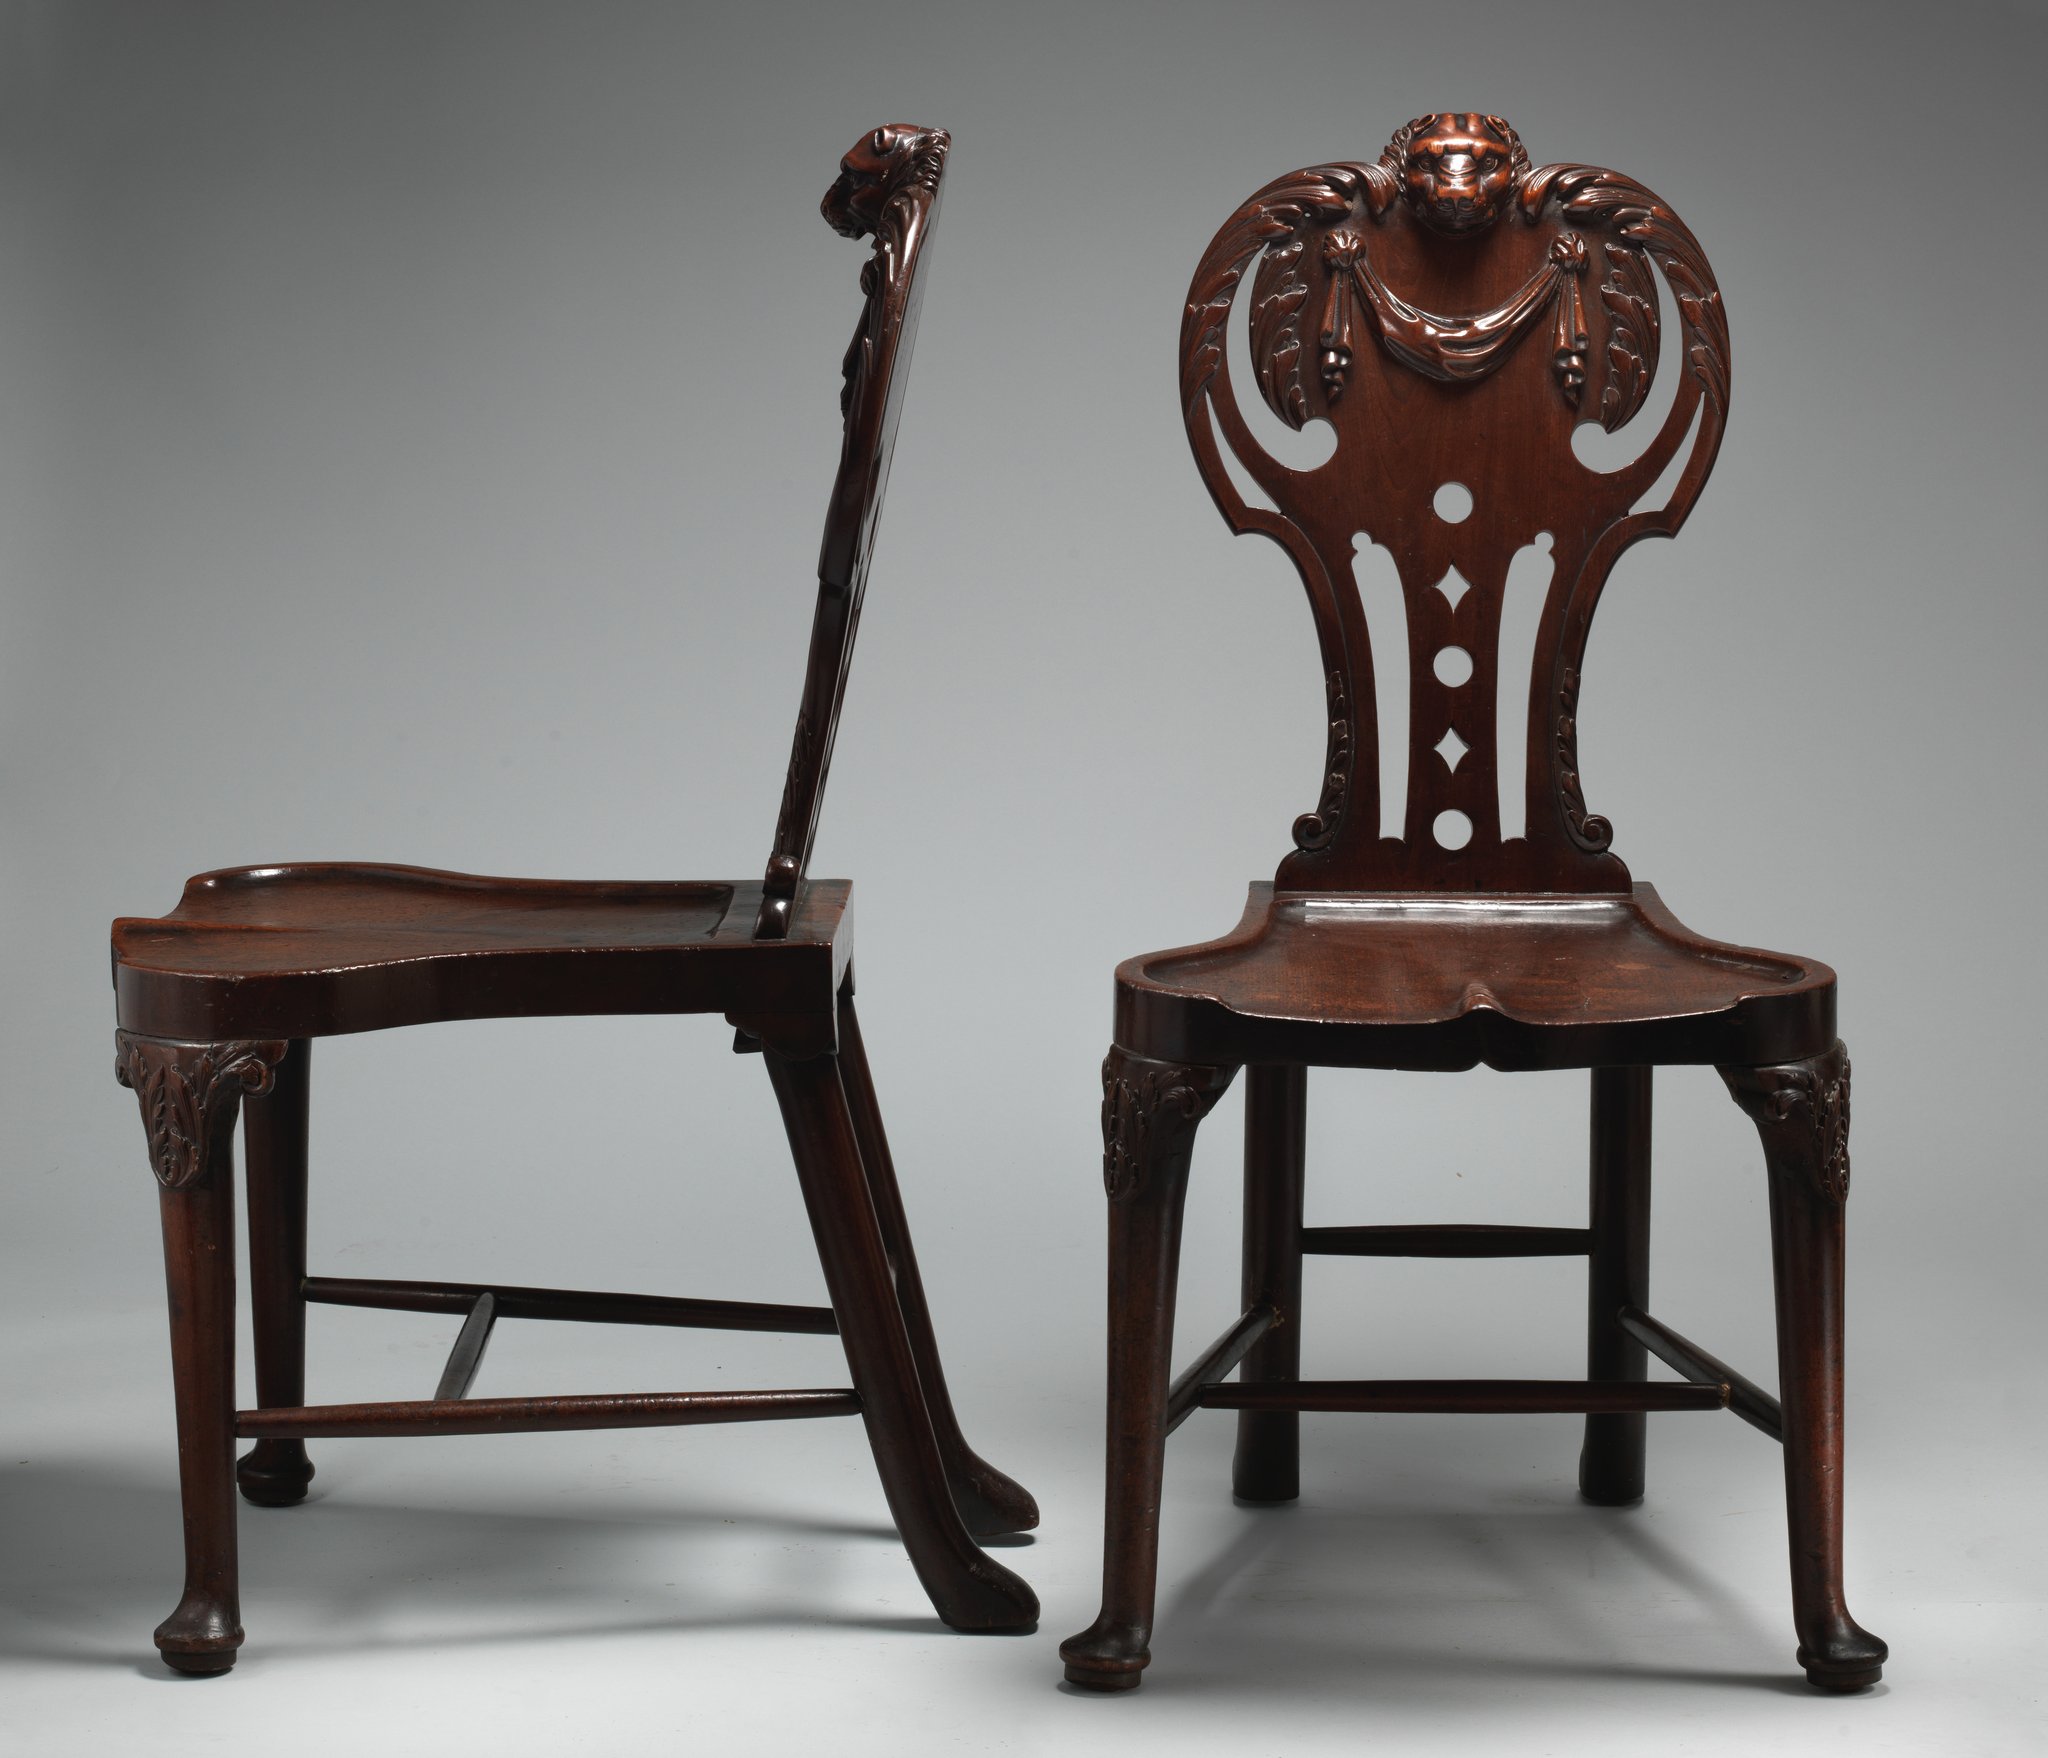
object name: hall chair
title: Pair of hall chairs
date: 1740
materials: wood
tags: animals